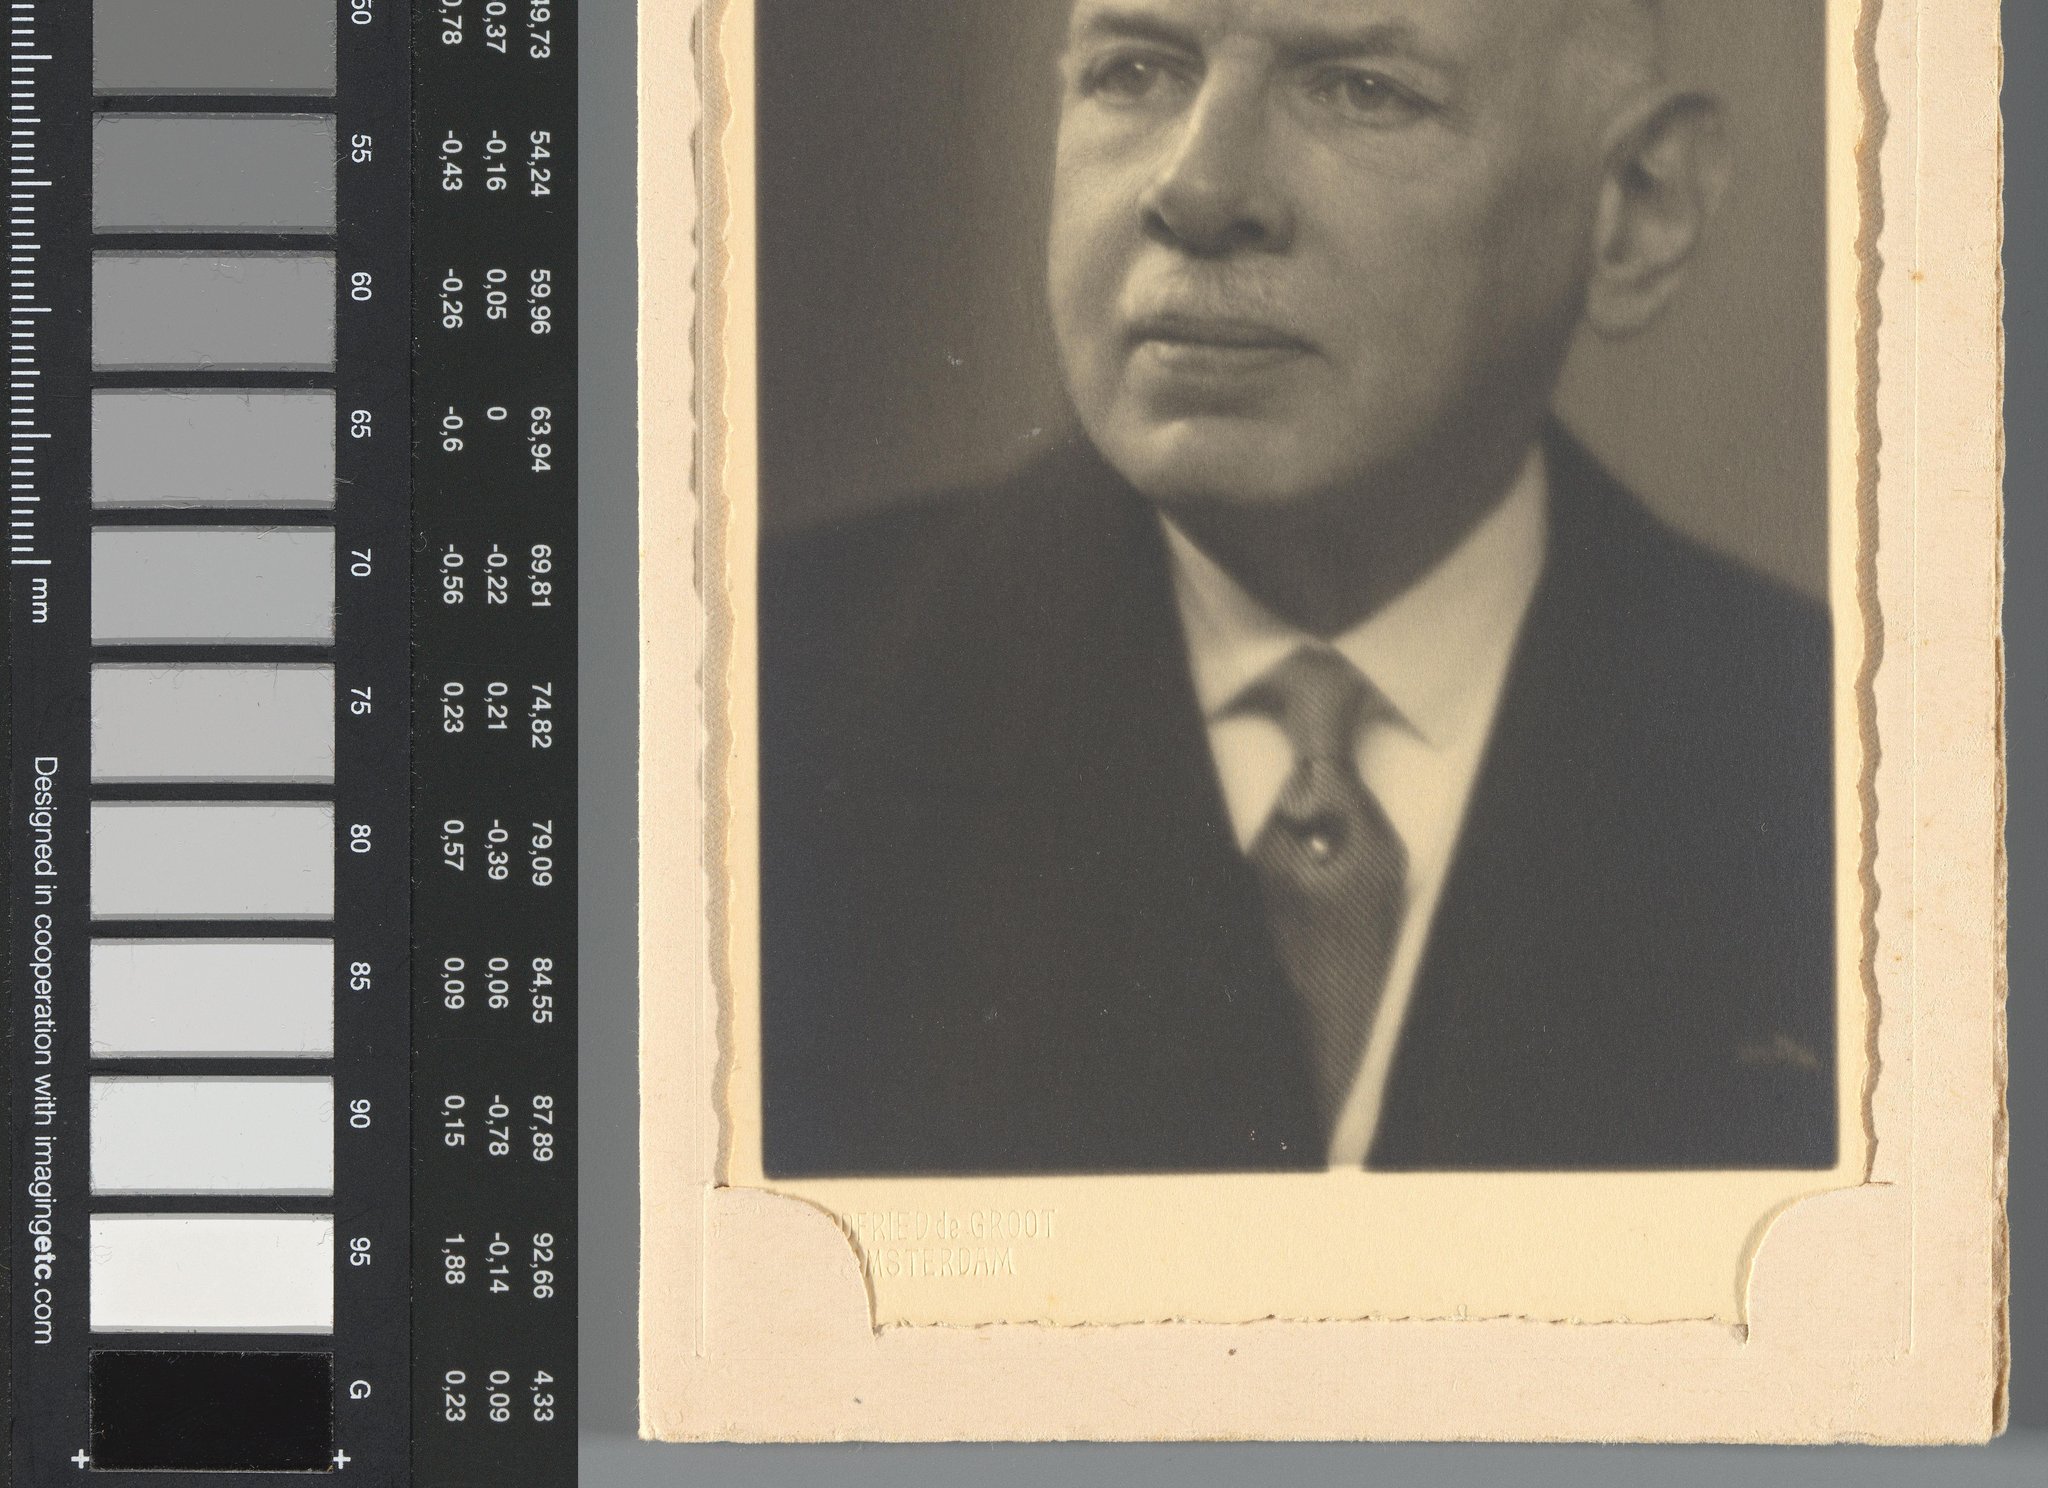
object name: passe partout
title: Portret in passe-partout van Karel Frederik van den Berg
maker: godfried de groot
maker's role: fotograaf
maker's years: 1894-1963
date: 1930-1945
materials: cardboard, photographic support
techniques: photography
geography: amsterdam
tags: batavia, karel frederik van den berg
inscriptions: name: ‘GODFRIED de GROOT / AMSTERDAM’